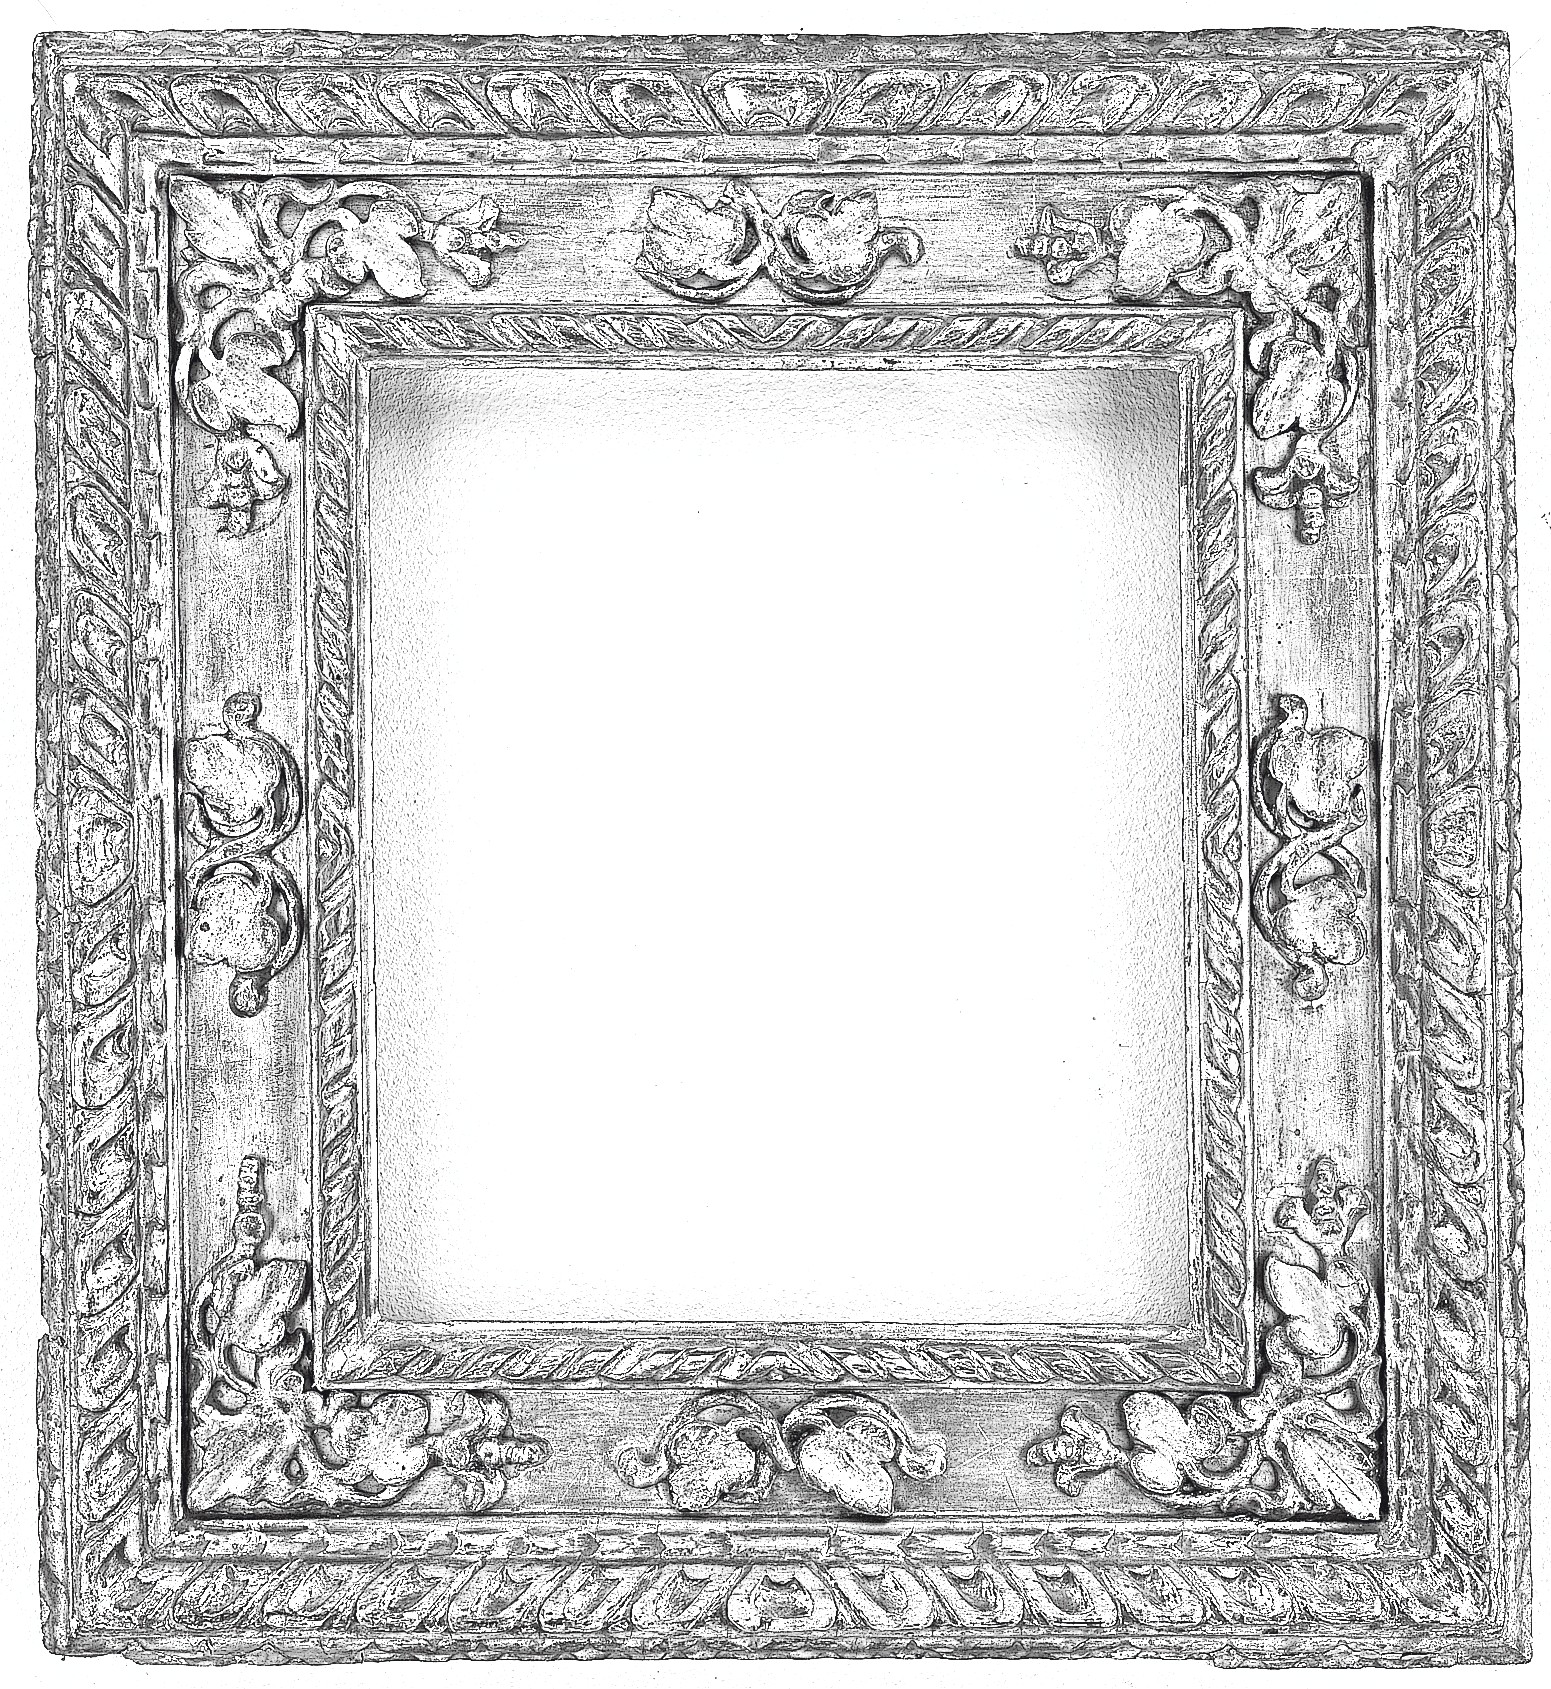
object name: frame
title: Cassetta frame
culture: italian, lombardy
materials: wood